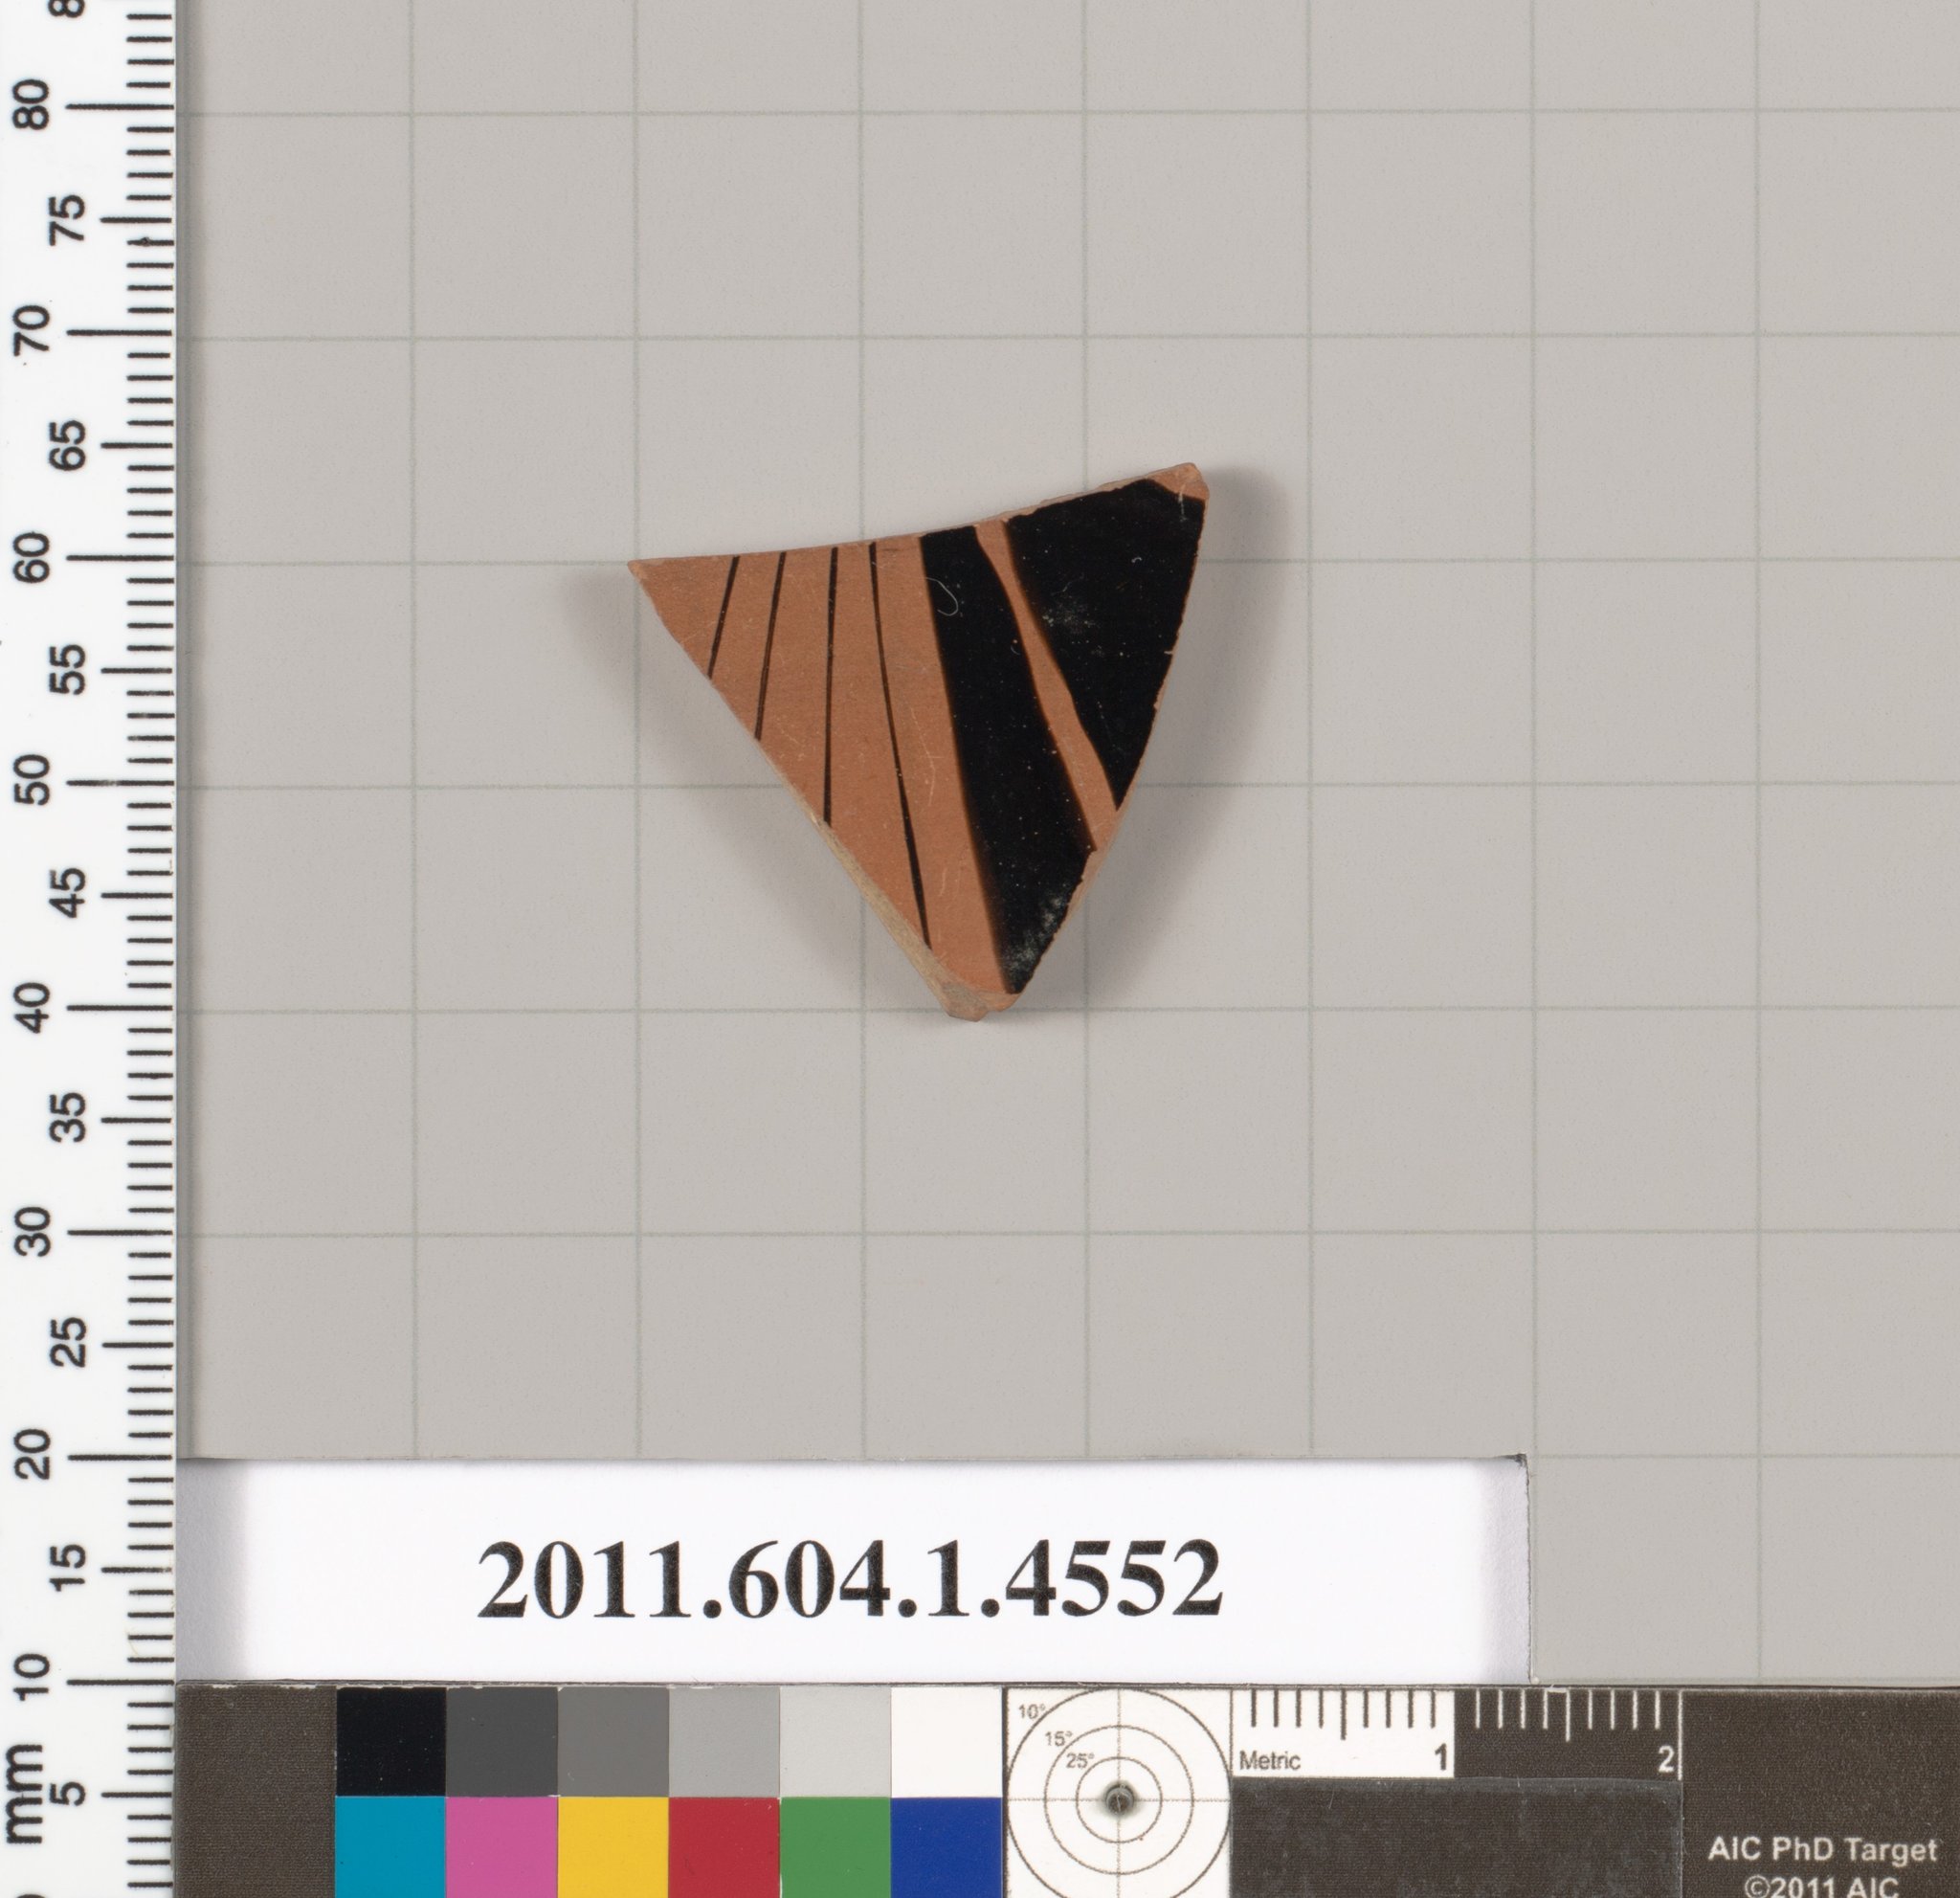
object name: kylix fragment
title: Terracotta fragment of a kylix (drinking cup)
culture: greek, attic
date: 475-451 BCE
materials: terracotta